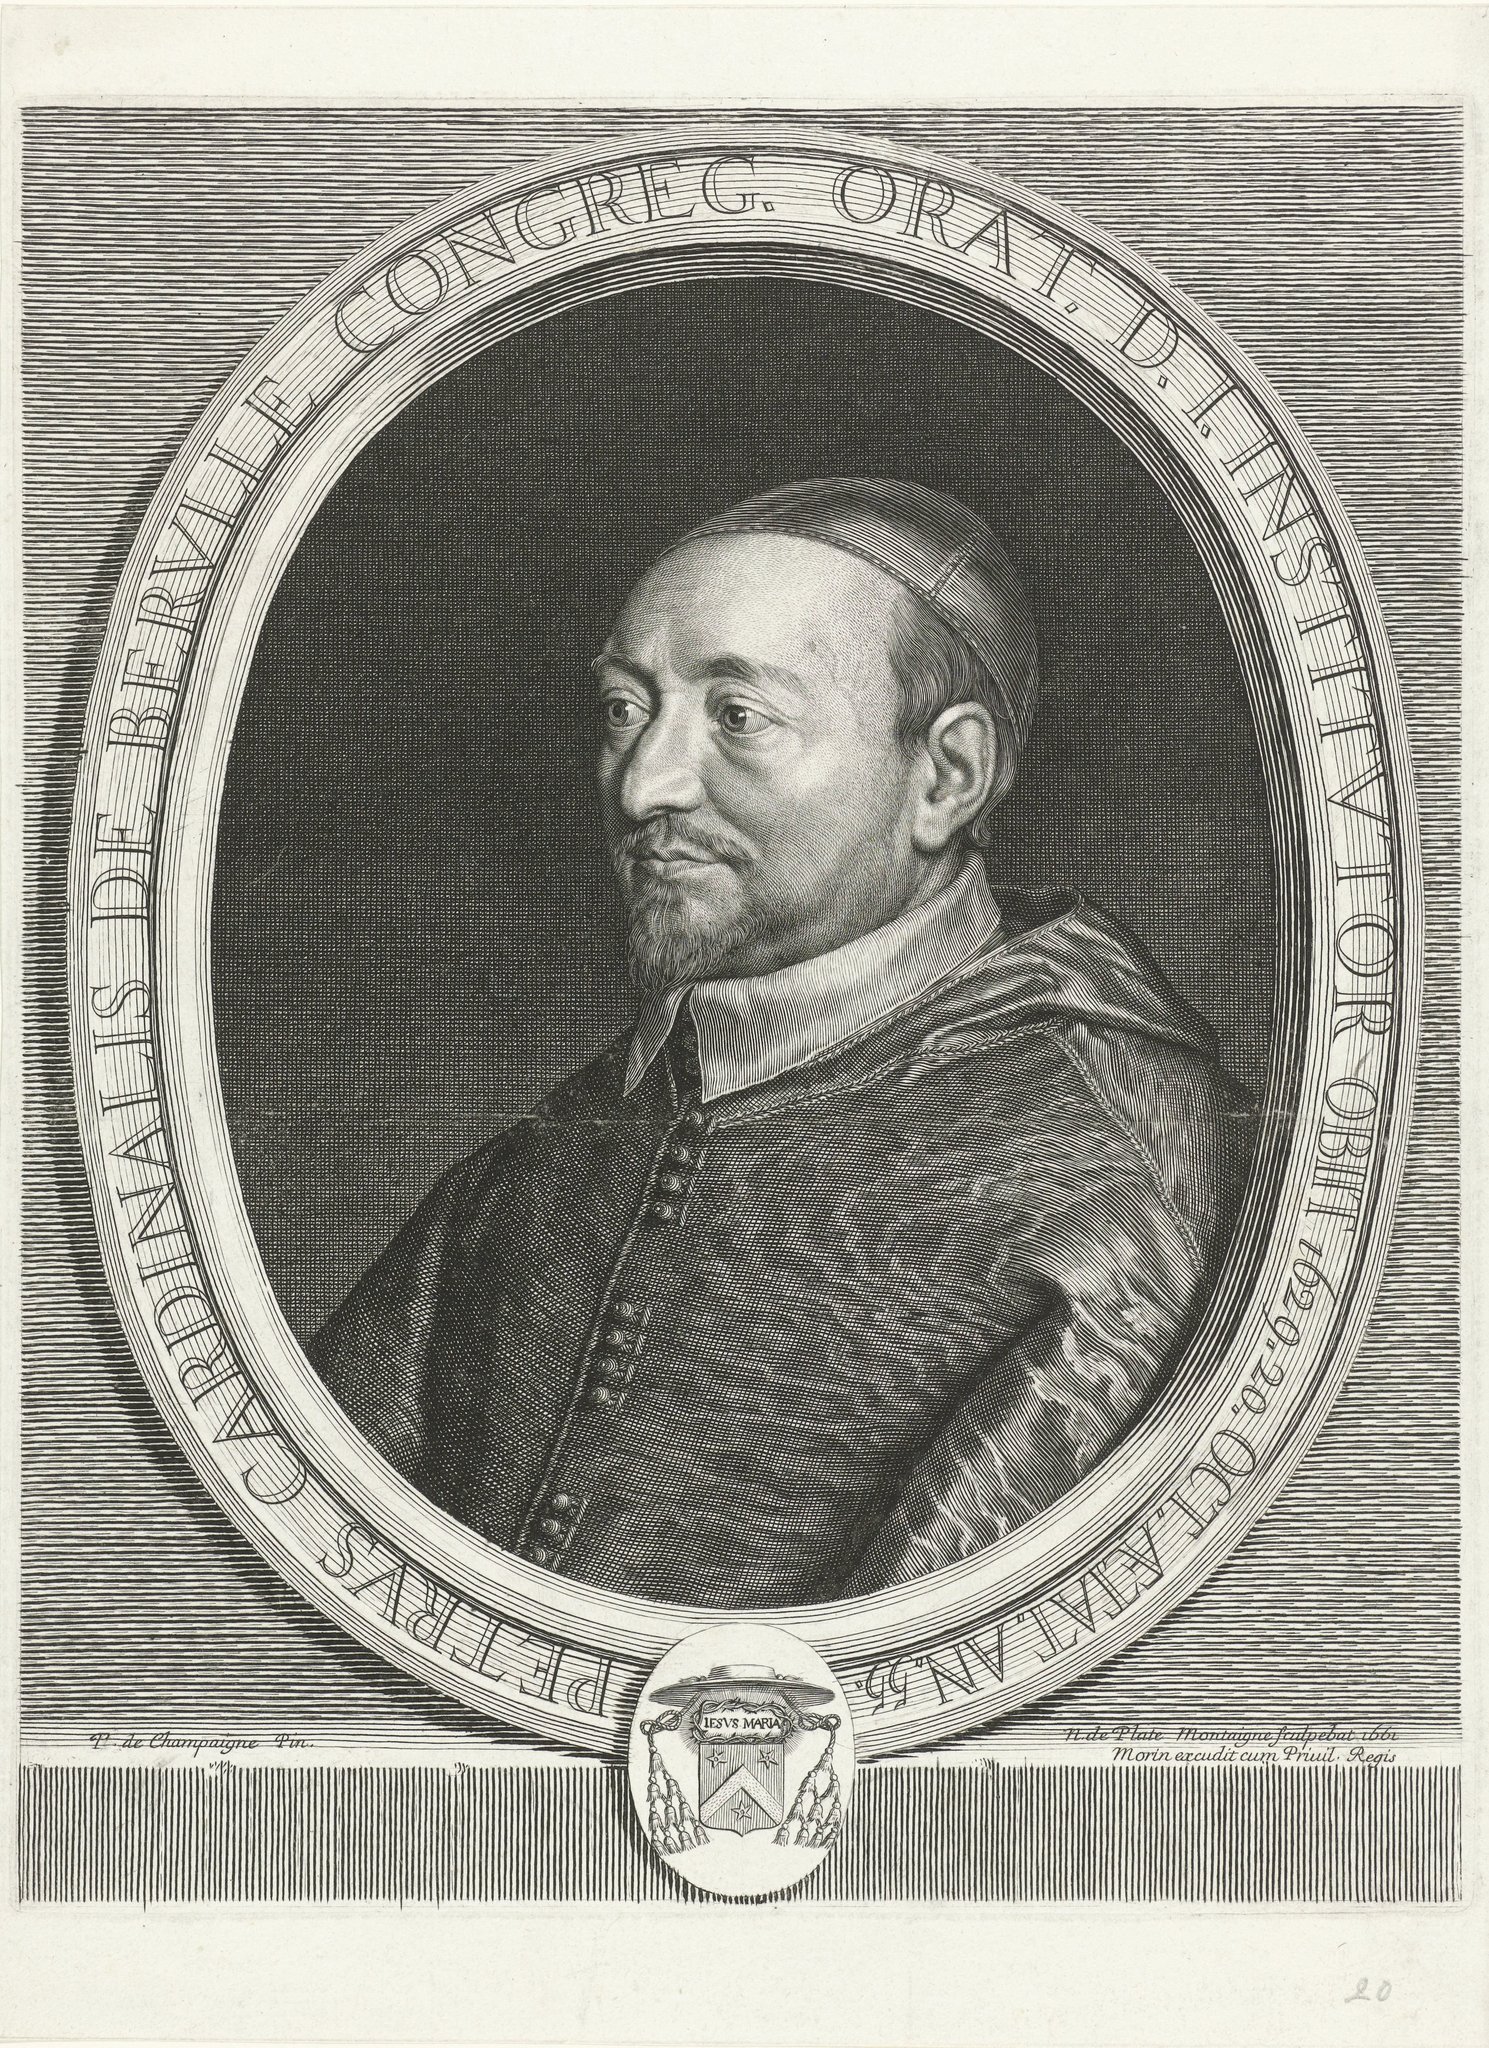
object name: print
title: Portret van Pierre de Bérulle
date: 1661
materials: paper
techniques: engraving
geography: paris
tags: insignia of cardinal, e.g. hat, mantle, armorial bearing, heraldry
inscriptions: collector's mark: Lugt 240, number: ‘73. - 27’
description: Portret van de Franse kardinaal Pierre de Bérulle. Onder de omlijsting zijn kardinaalswapen.